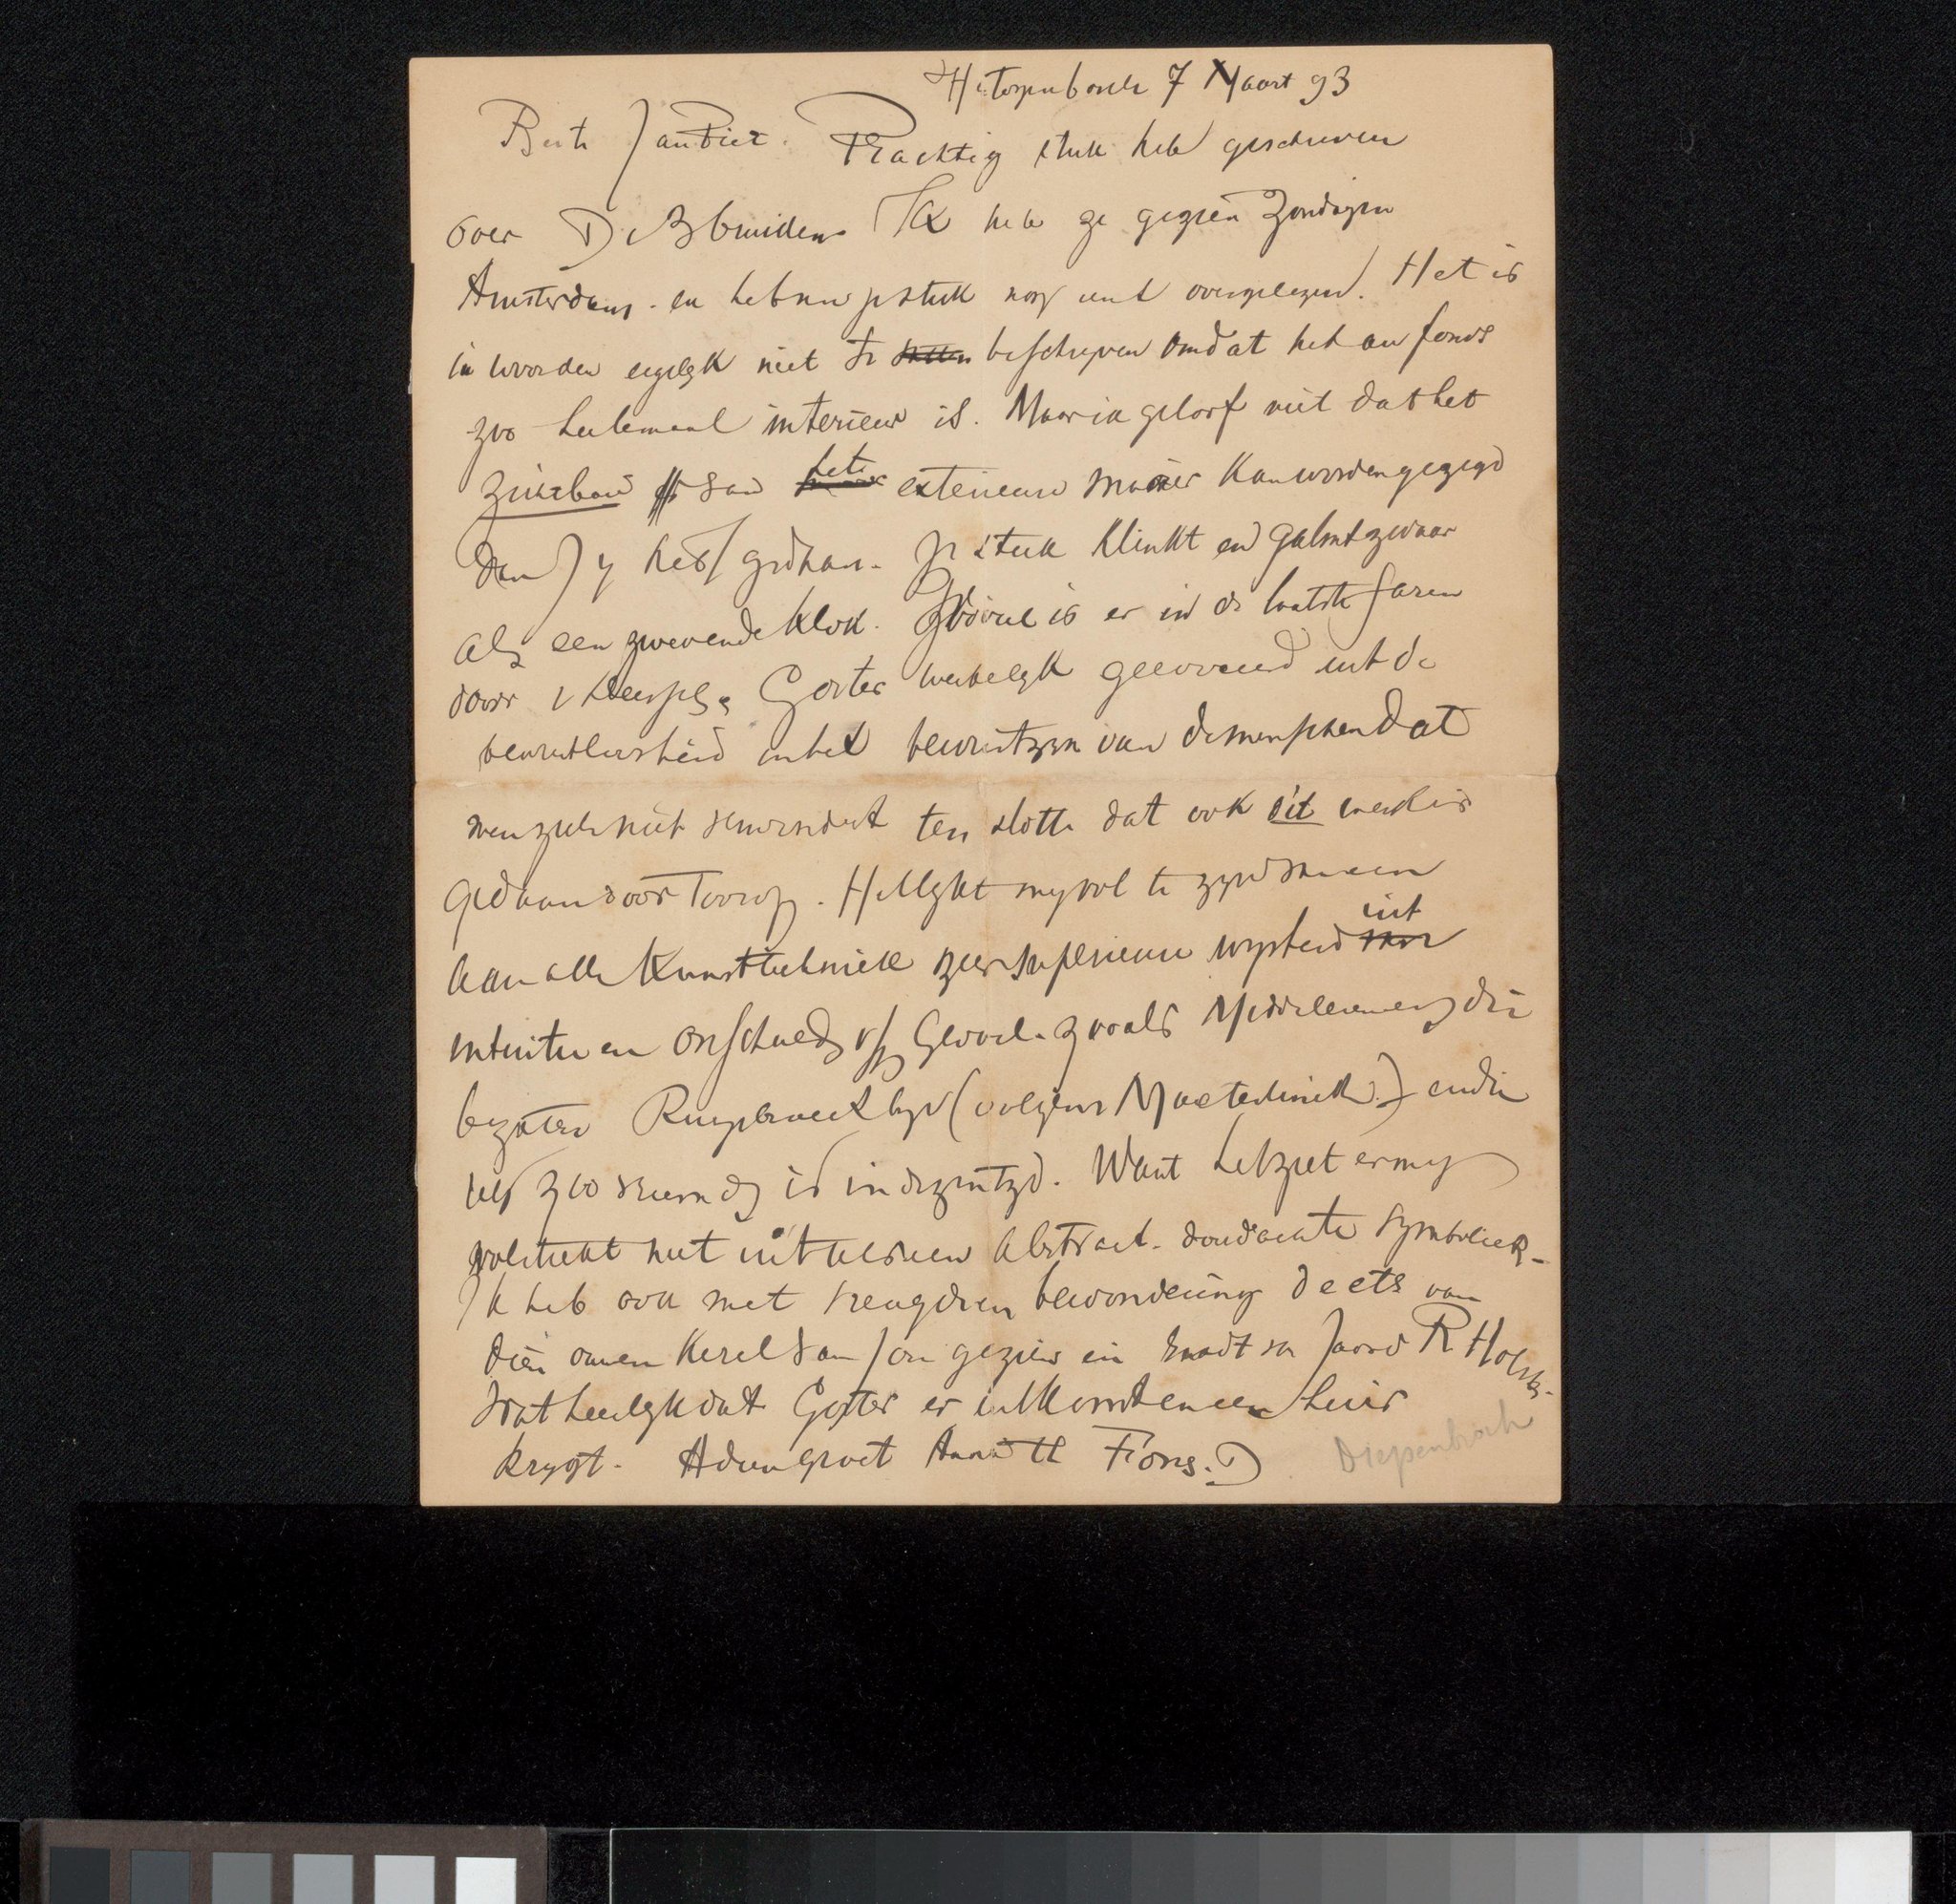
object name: letter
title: Brief aan Jan Veth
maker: alphons diepenbrock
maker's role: componist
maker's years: 1862-1921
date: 1893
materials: ink, paper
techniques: pen, writing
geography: den bosch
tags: dordrecht, amsterdam, painter, draughtsman, designer, jan veth, the hague, jan toorop, lodewijk van deyssel, herman gorter, ghent, maurice maeterlinck, drawing, the graphic arts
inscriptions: collector's mark: ‘RPK’, watermark